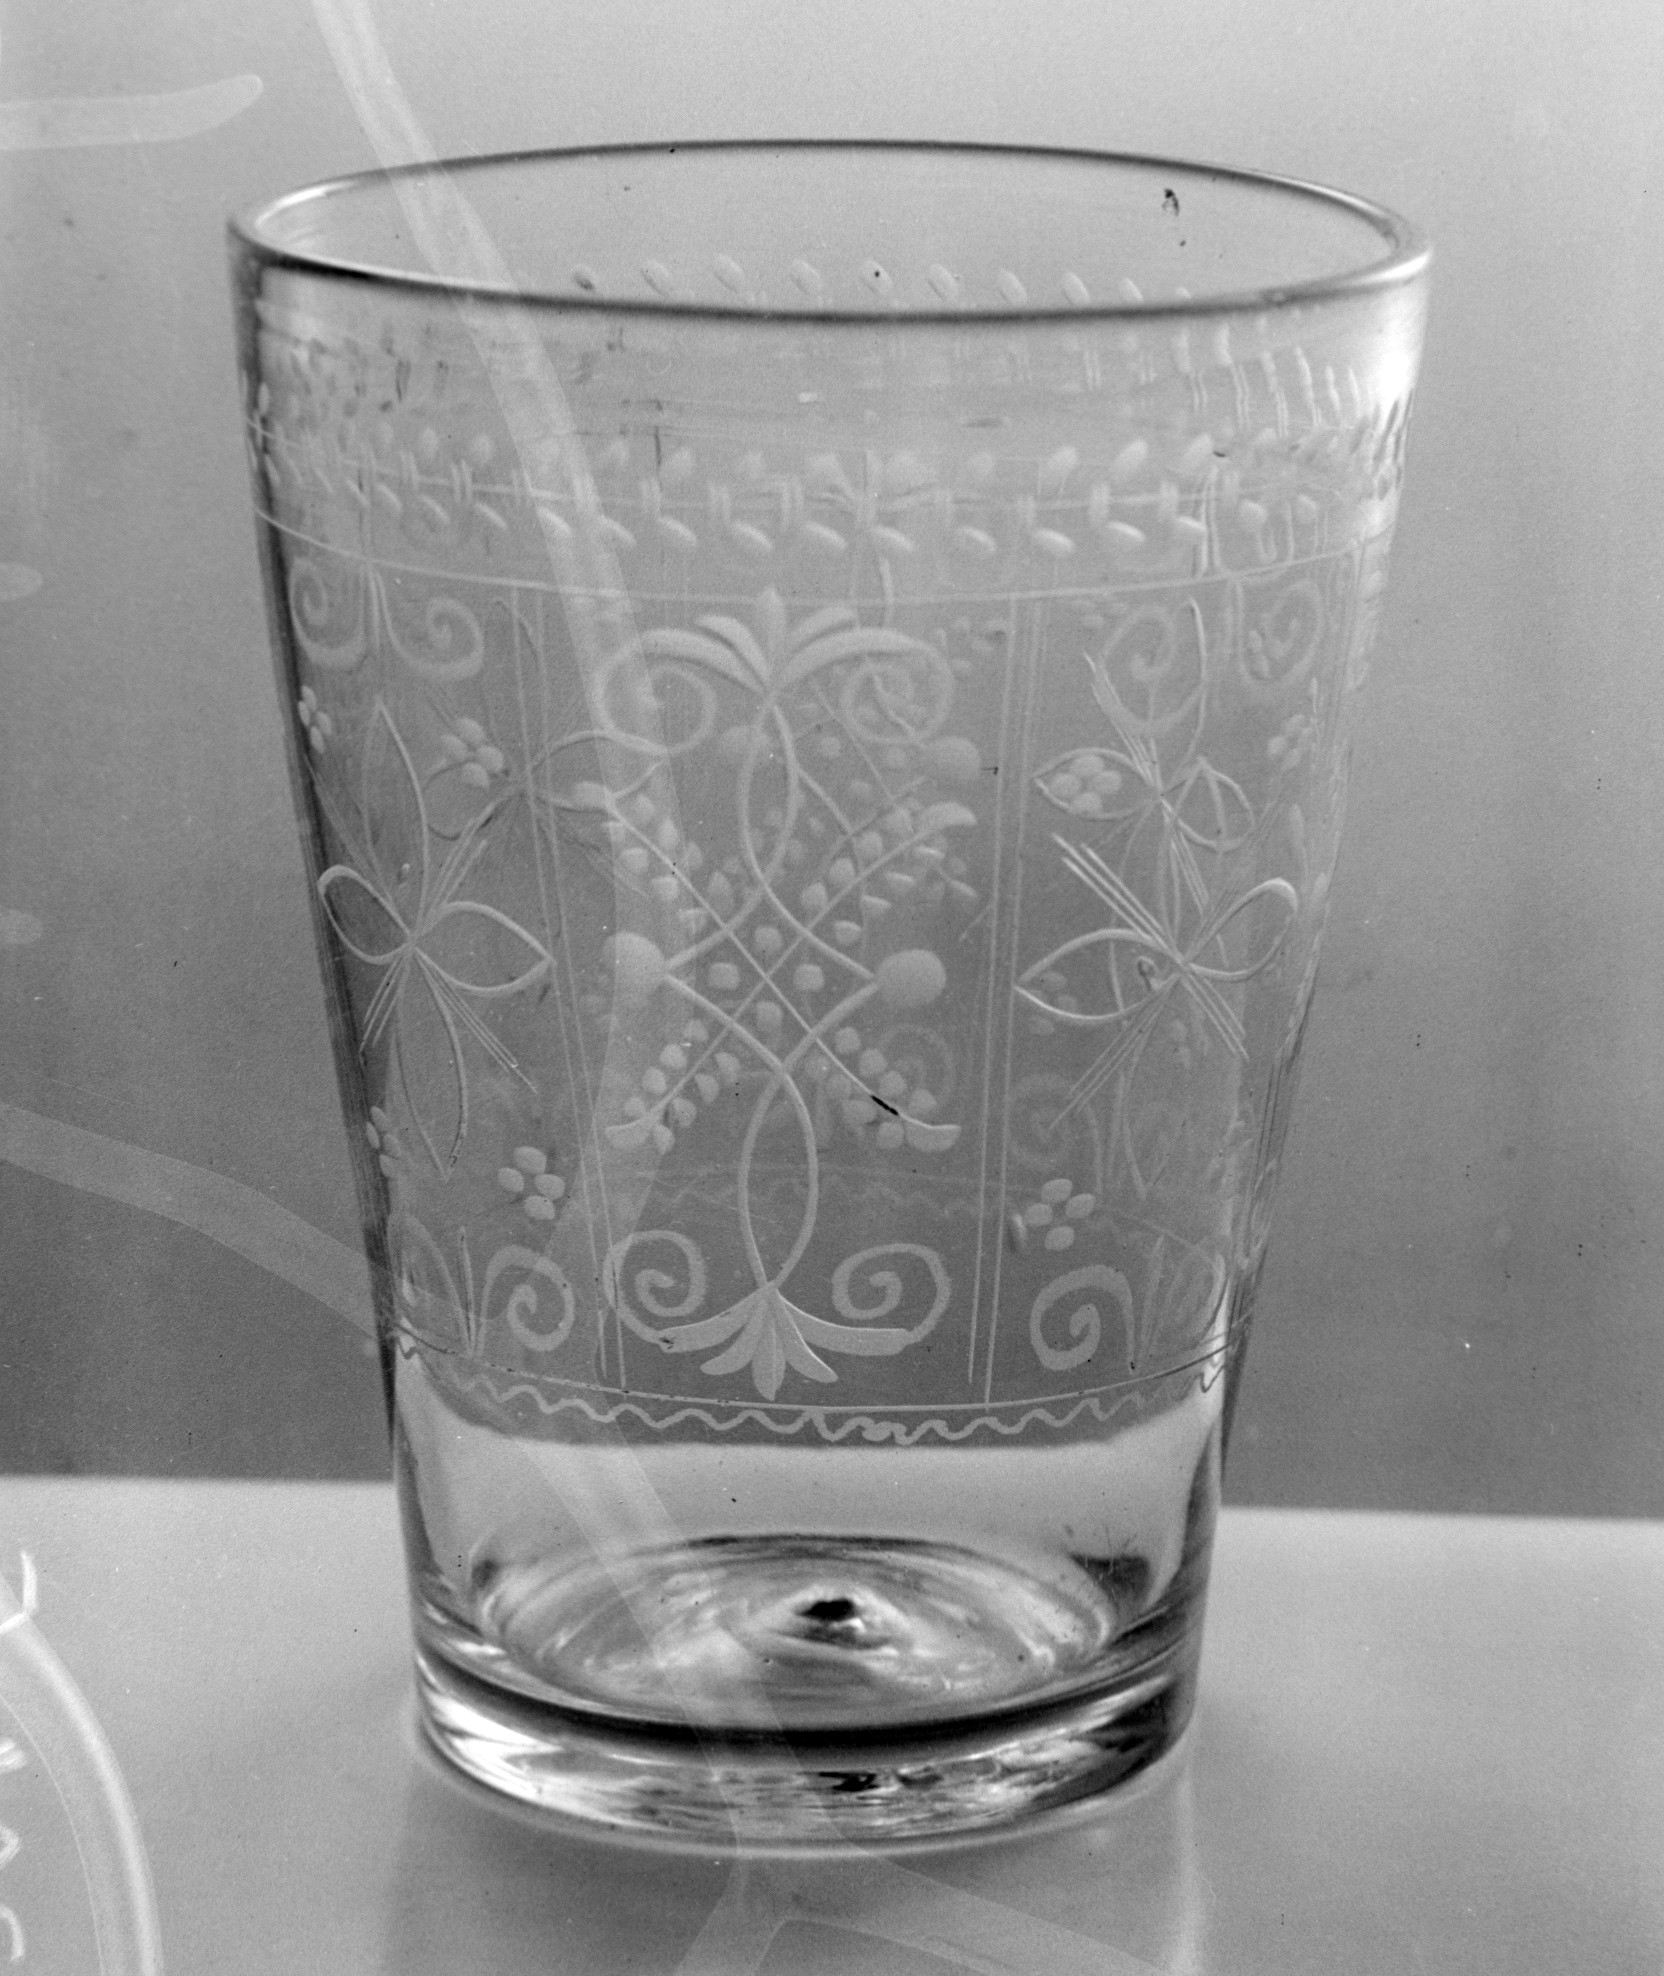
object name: flip or toddy glass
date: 1701-1800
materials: glass